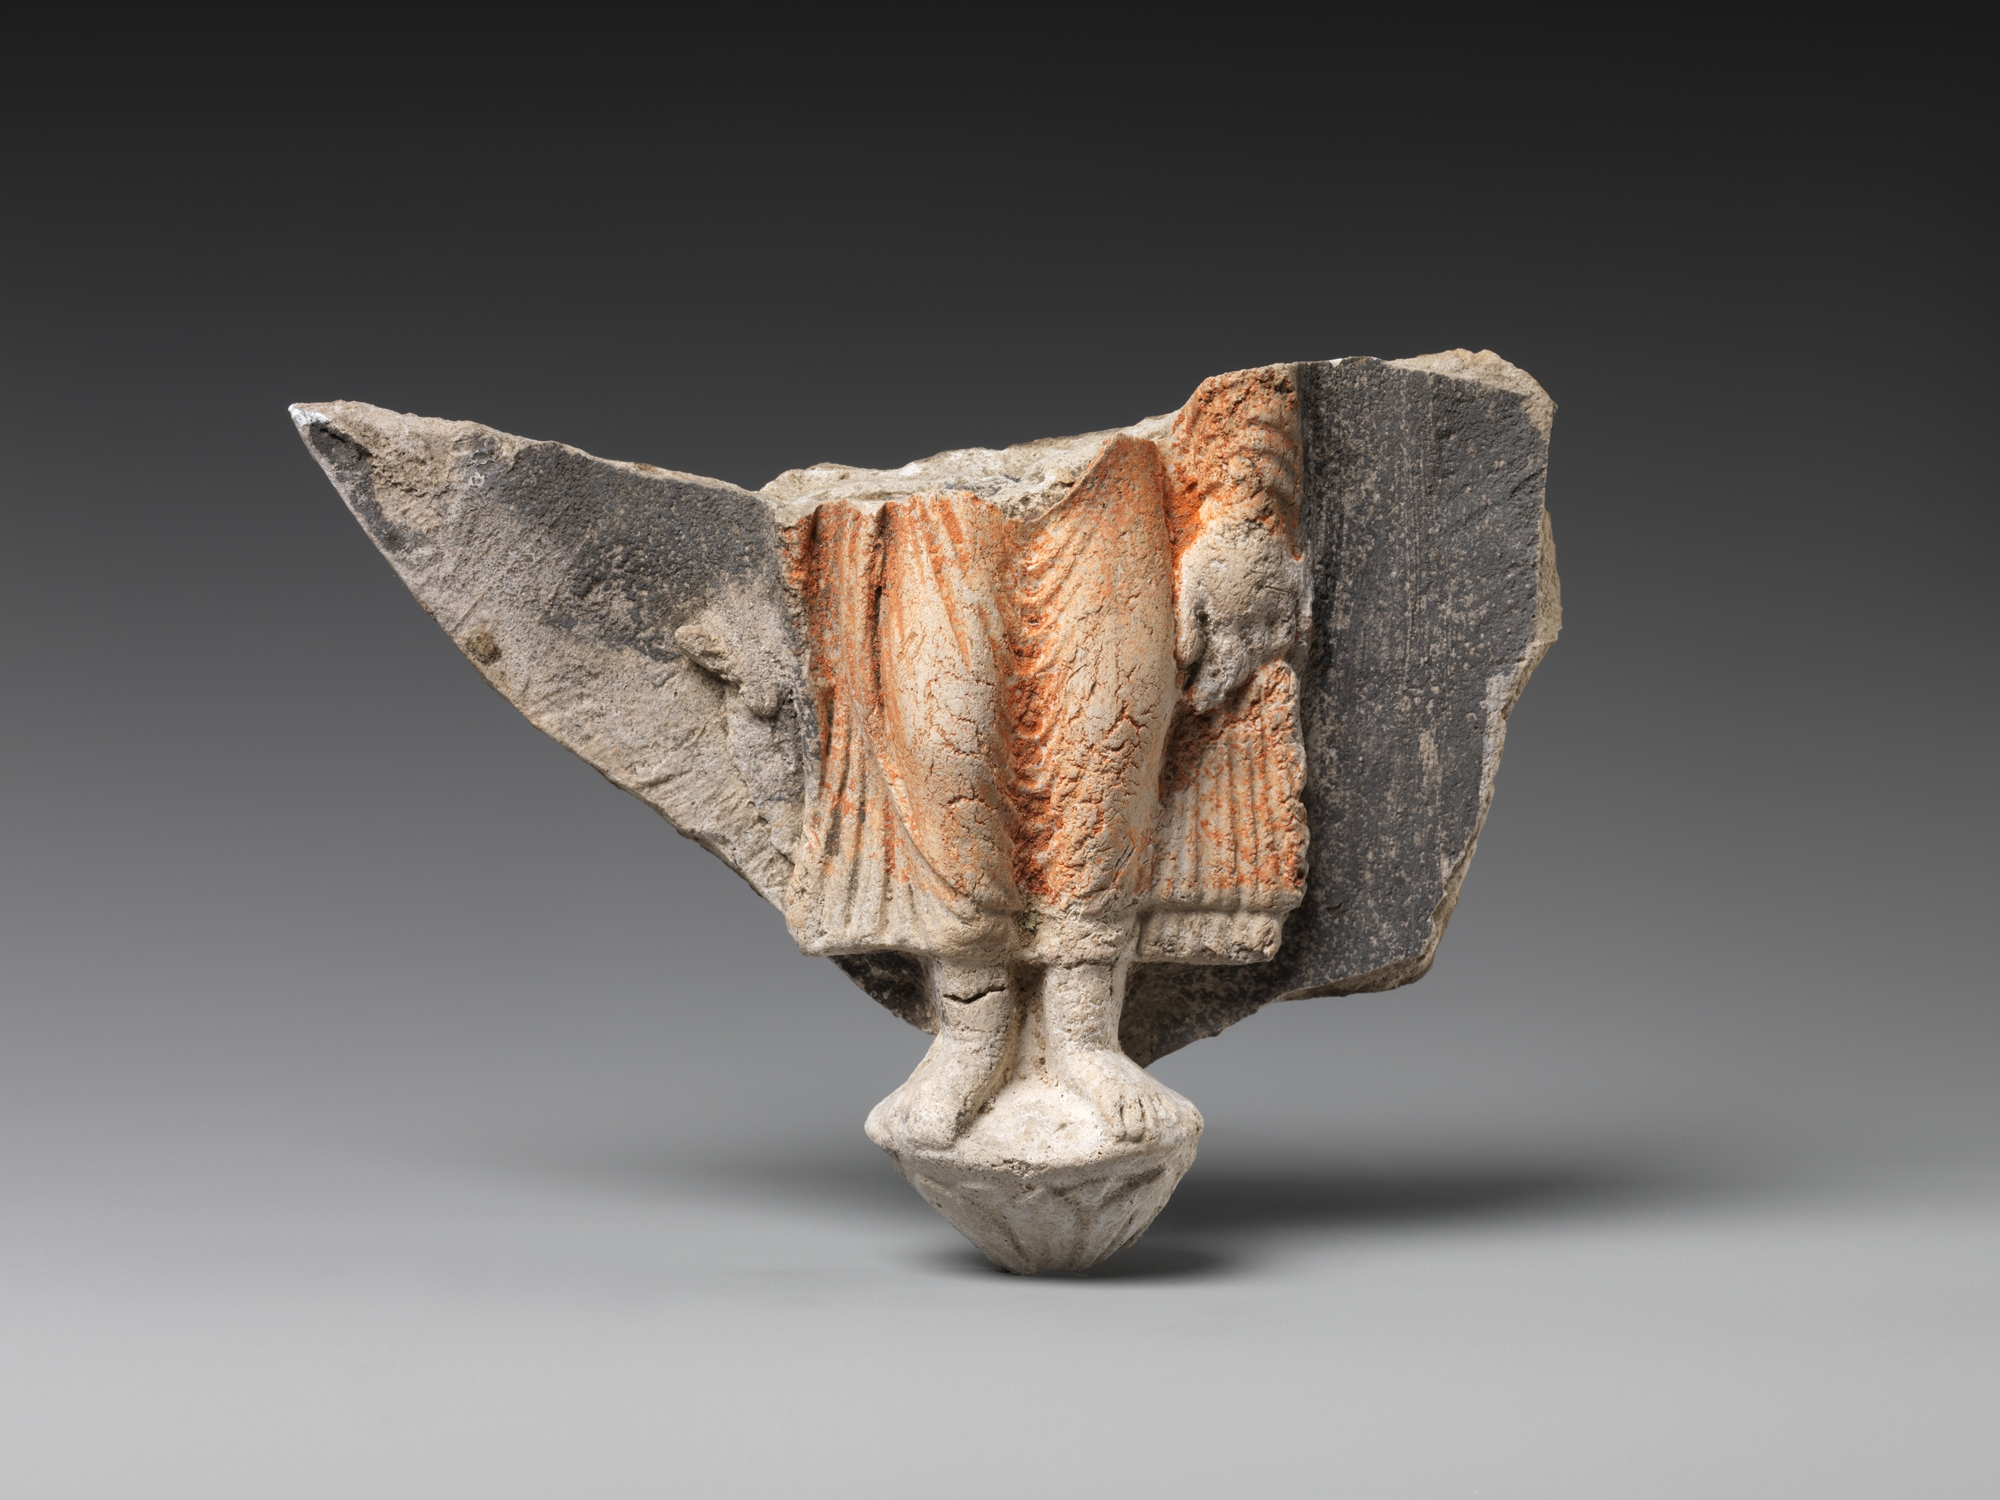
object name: relief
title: Fragment of a Halo with Buddha Figure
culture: chinese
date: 501-700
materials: plaster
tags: buddhism,buddha